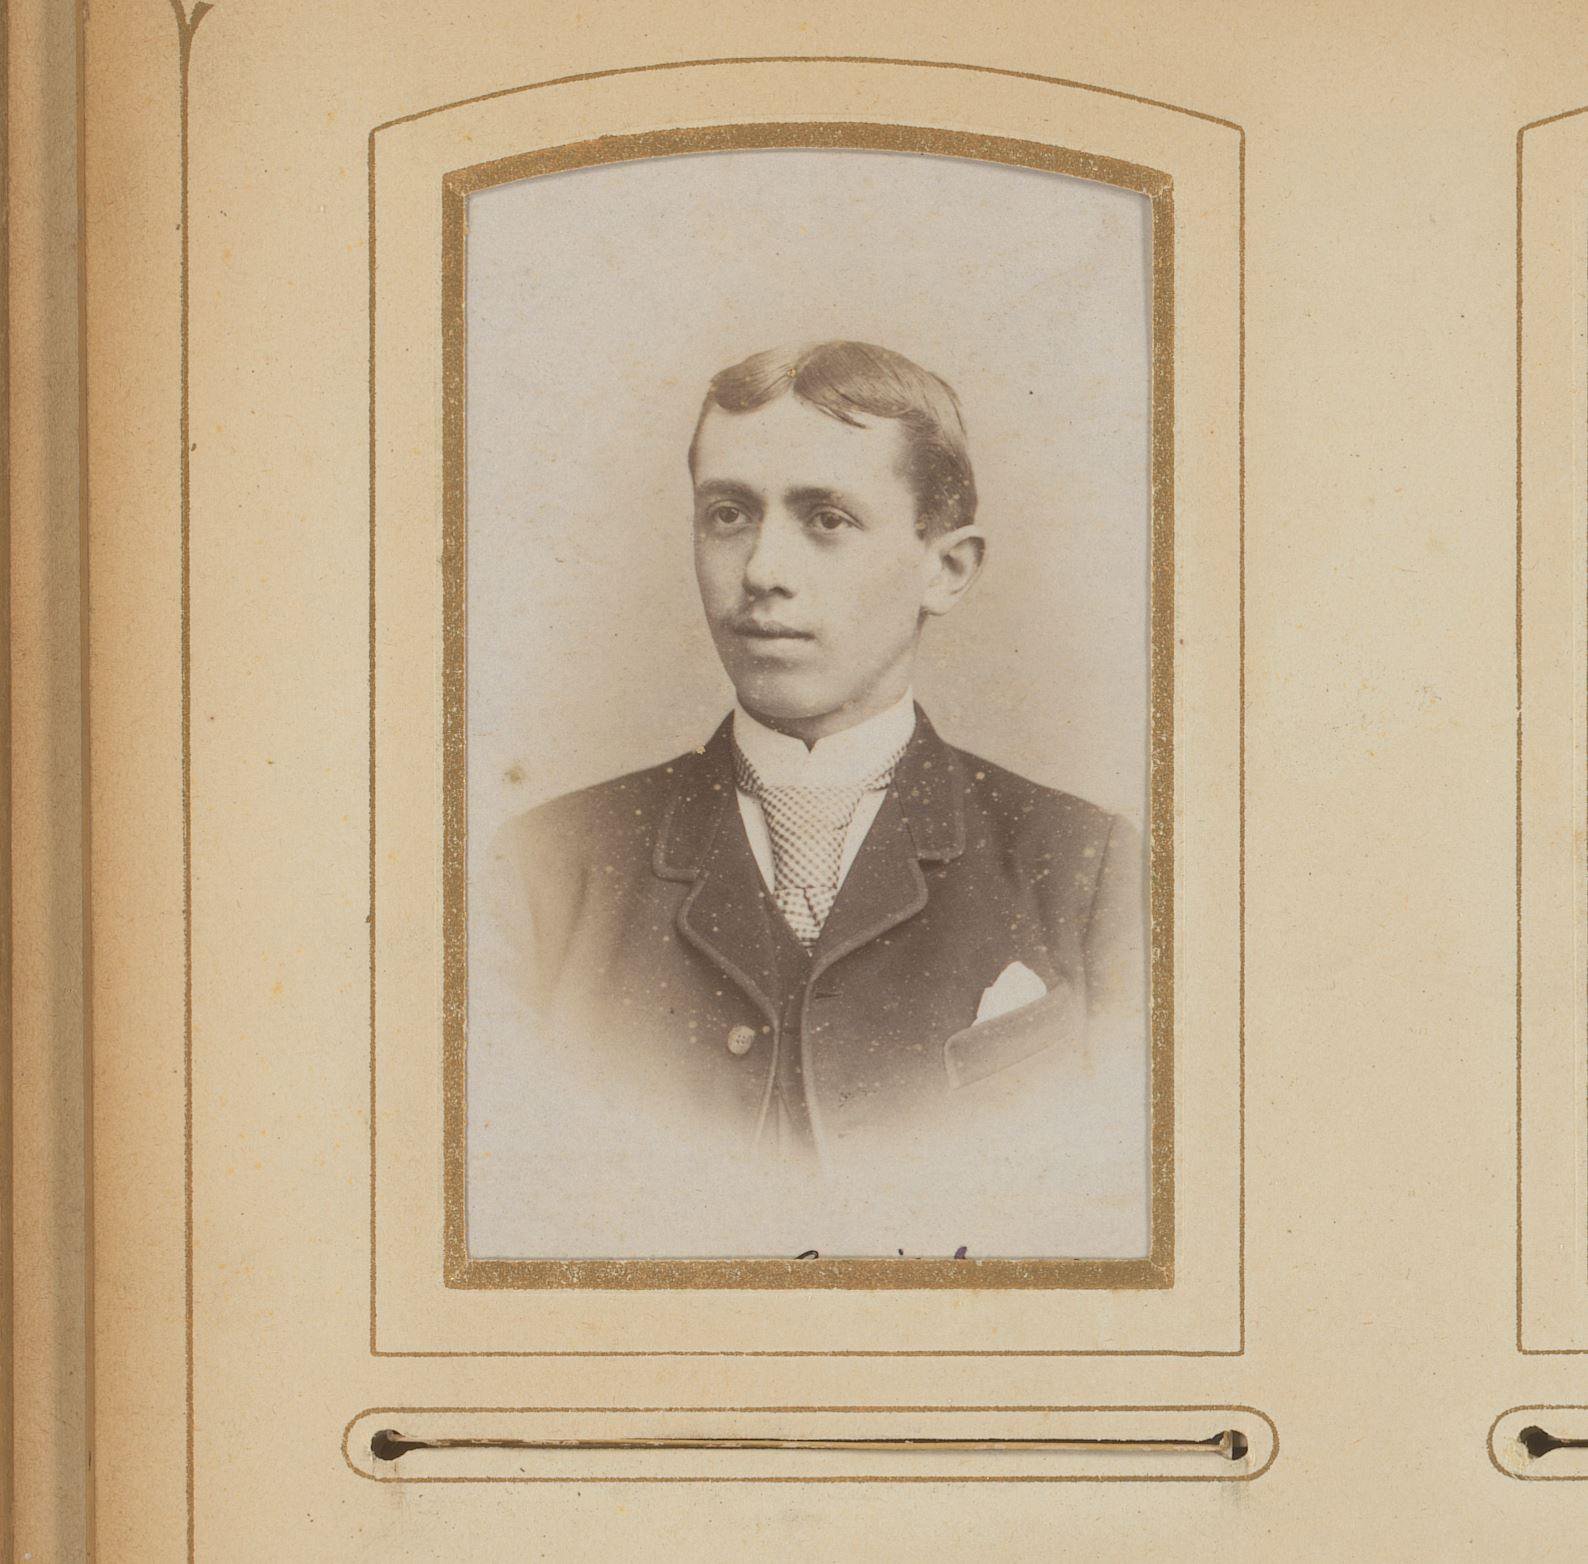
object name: album leaf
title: Portret van een jongeman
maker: bornemann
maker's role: fotograaf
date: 1890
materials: cardboard, photographic support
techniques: albumen print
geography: verden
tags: historical persons, youth, adolescent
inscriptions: inscription: ‘Bornemann/ Verden/ Lahusenstrasse 12’, date: ‘April 7. 1890’